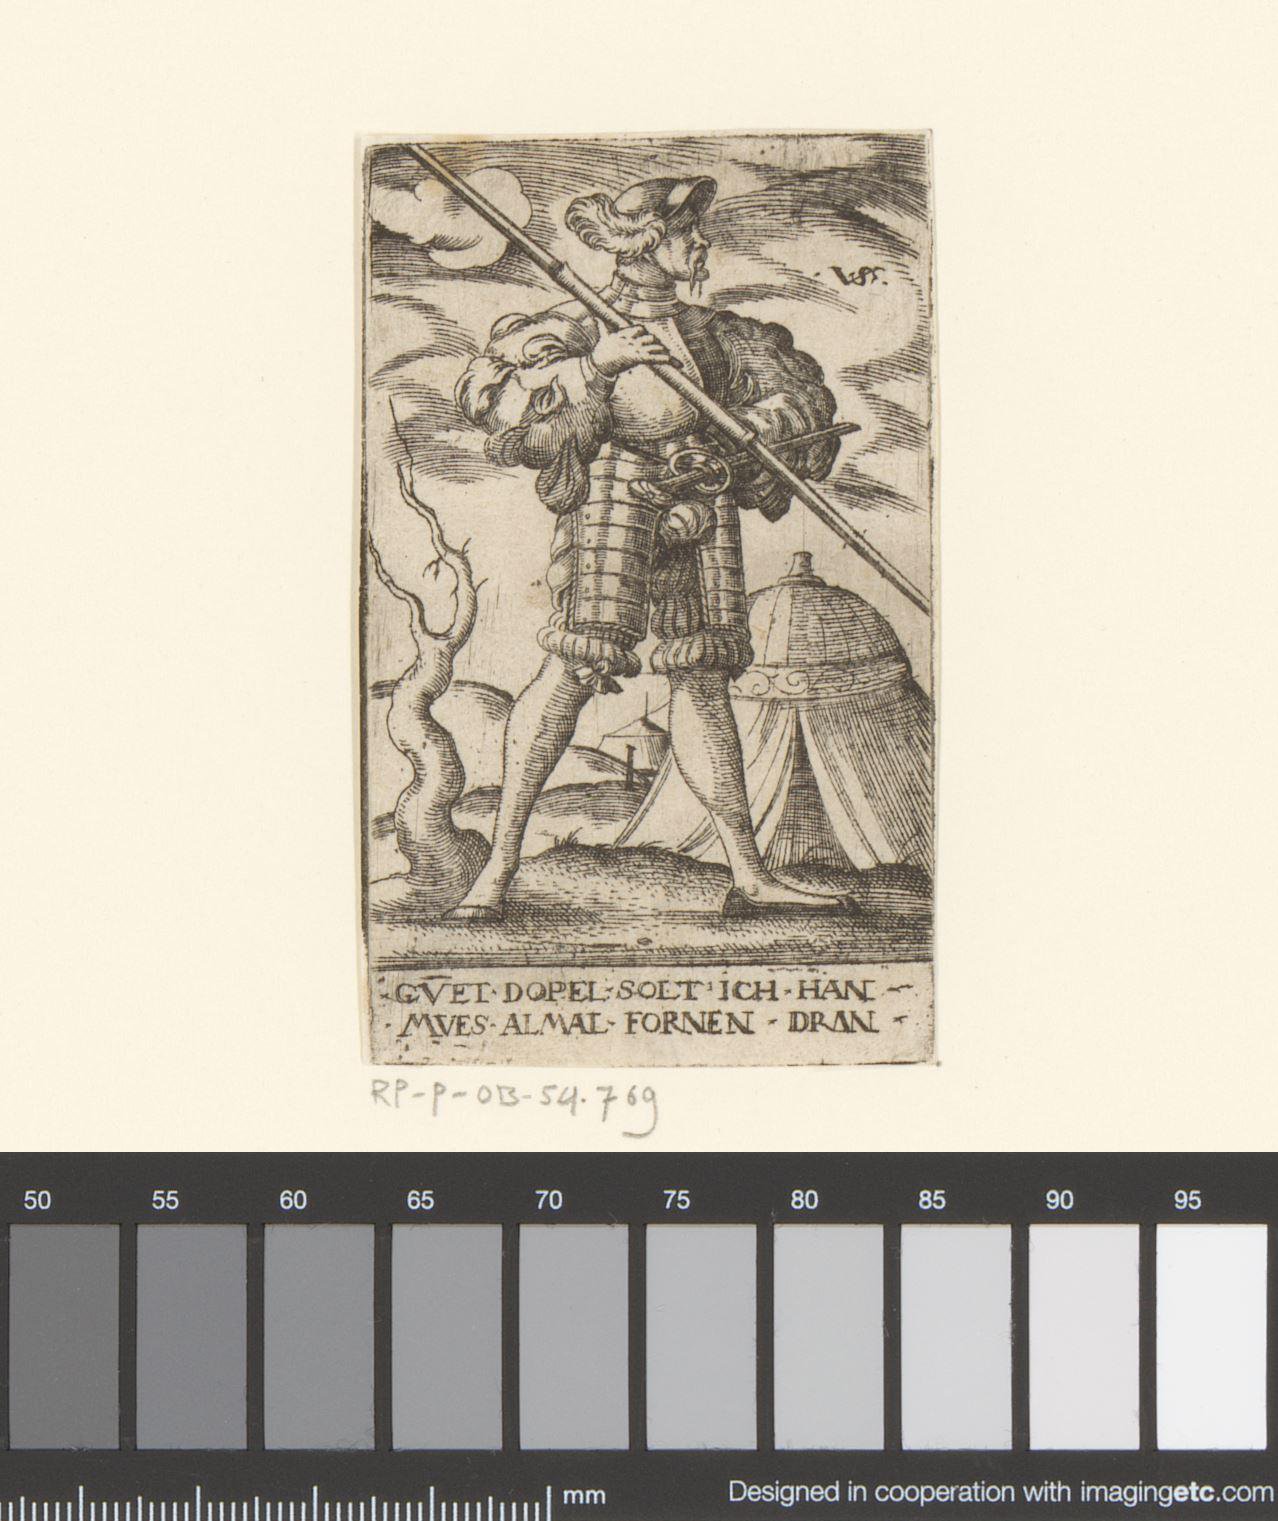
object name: print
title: Piekdrager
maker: virgilius solis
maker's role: draughtsman, print maker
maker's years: 1514-1562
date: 1524-1562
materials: paper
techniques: engraving, etching, intaglio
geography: nuremberg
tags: helved weapons, polearms (for striking, hacking, thrusting): pike, ranks in the army, the soldier; the soldier's life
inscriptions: collector's mark: Lugt 2228, number: ‘141’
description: Prent maakt deel uit van een serie bestaande uit twaalf prenten met militaire figuren van verschillende rangen.